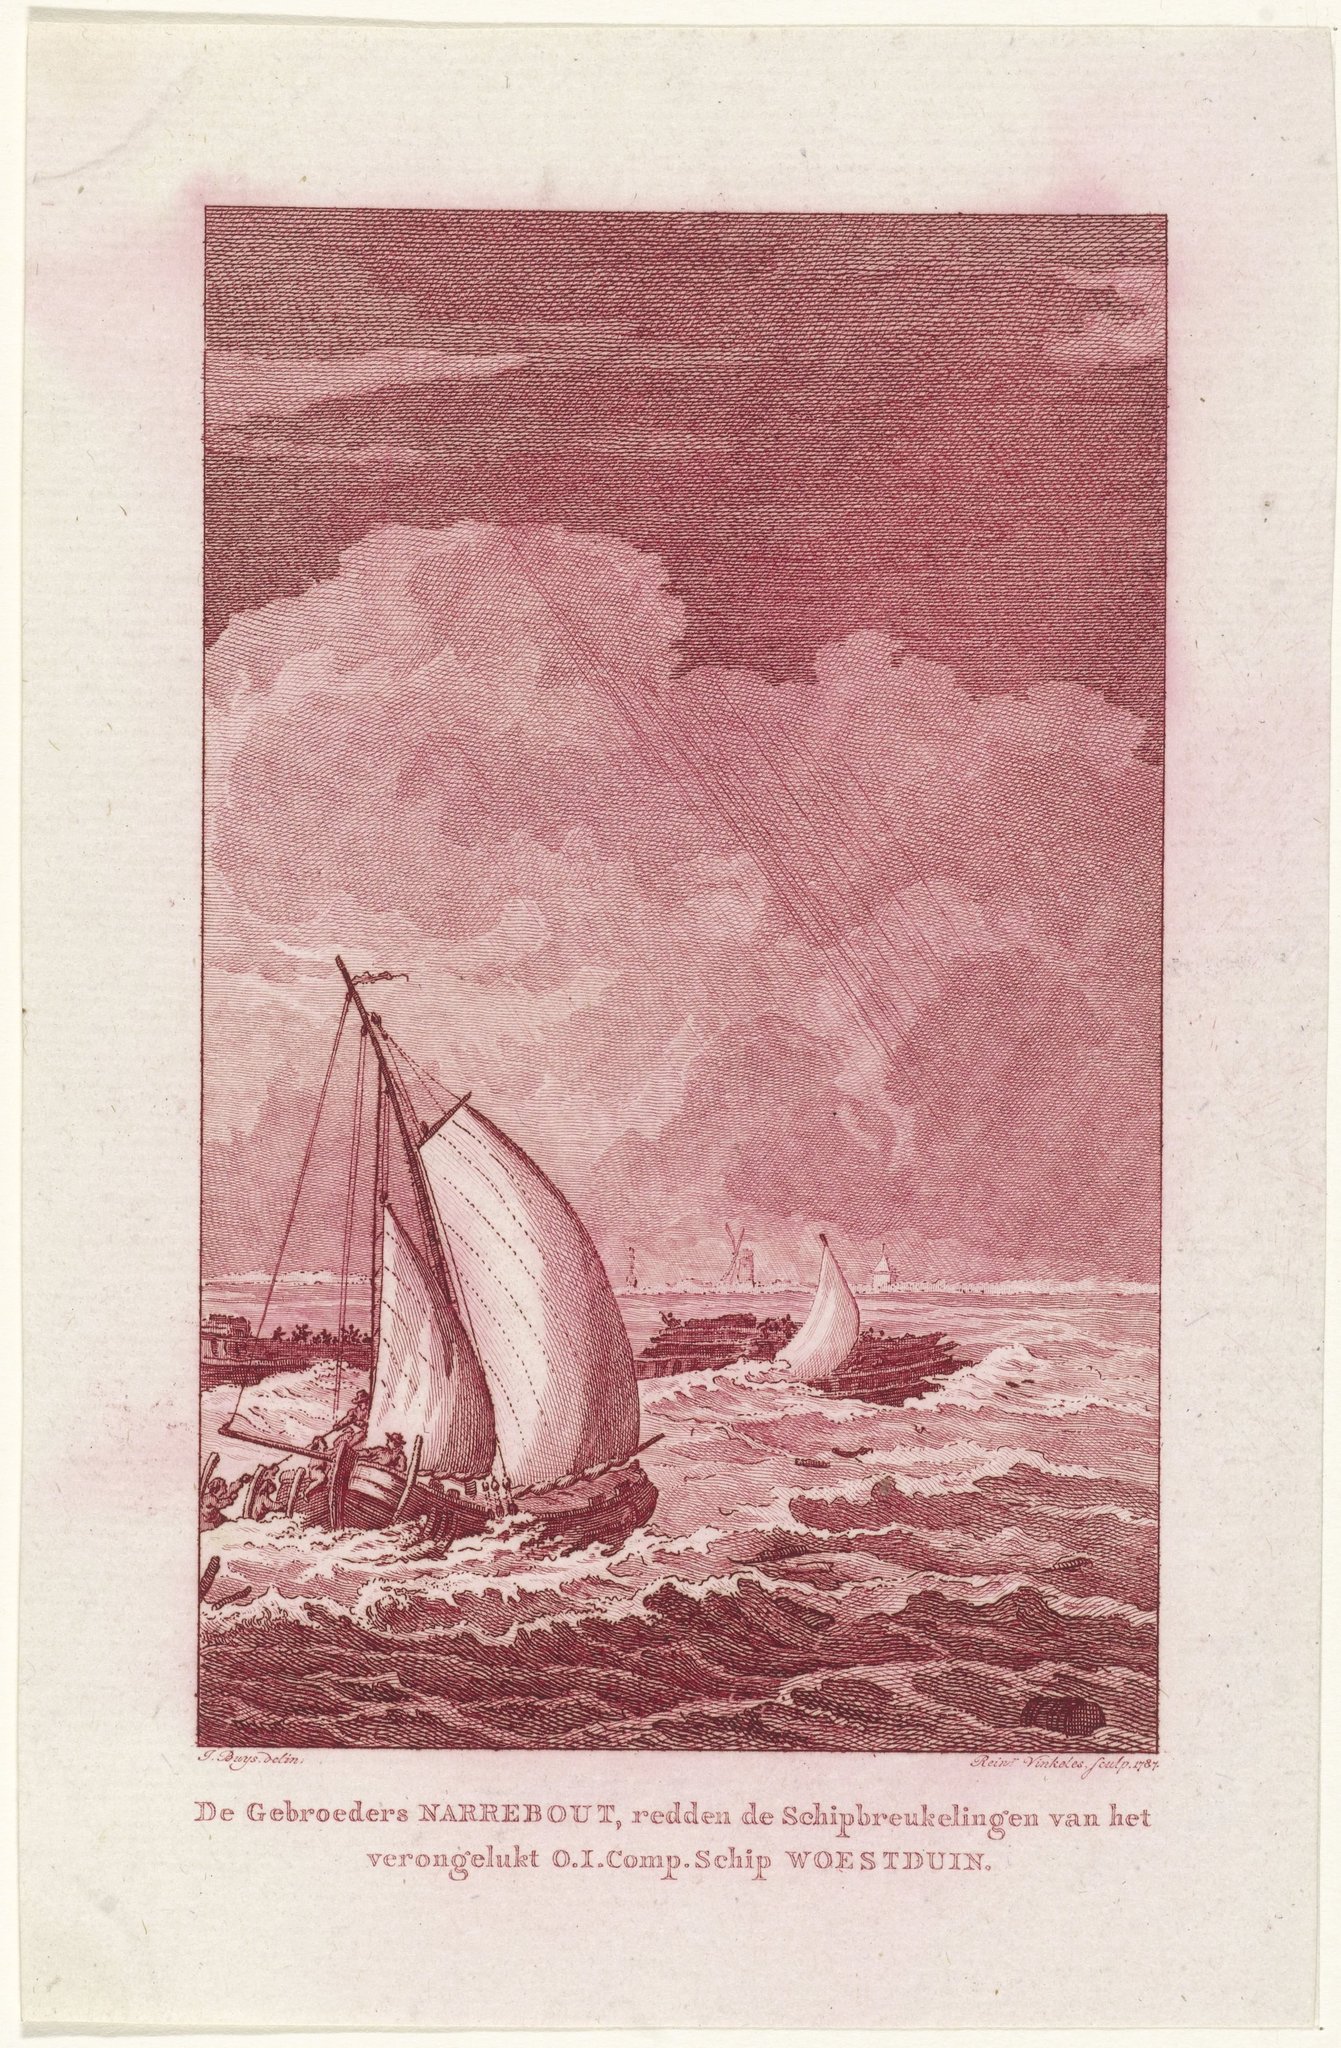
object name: history print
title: De Gebroeders Narrebout, redden de Schipbreukelingen van het verongelukt O.I.Comp. Schip Woestduin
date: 1787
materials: paper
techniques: engraving, etching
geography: northern netherlands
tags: shipwreck (+ saving the victims ~ traffic accident)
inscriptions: collector's mark: Lugt 2228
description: Gebruikt als illustratie in: P.A. Loosjes. Vaderlandsche historie, vervattende de geschiedenissen, der Vereenigde Nederlanden (...). Ten onmiddelyken vervolge van Wagenaar's Vaderlandsche historie. Amsterdam: J. Allart.